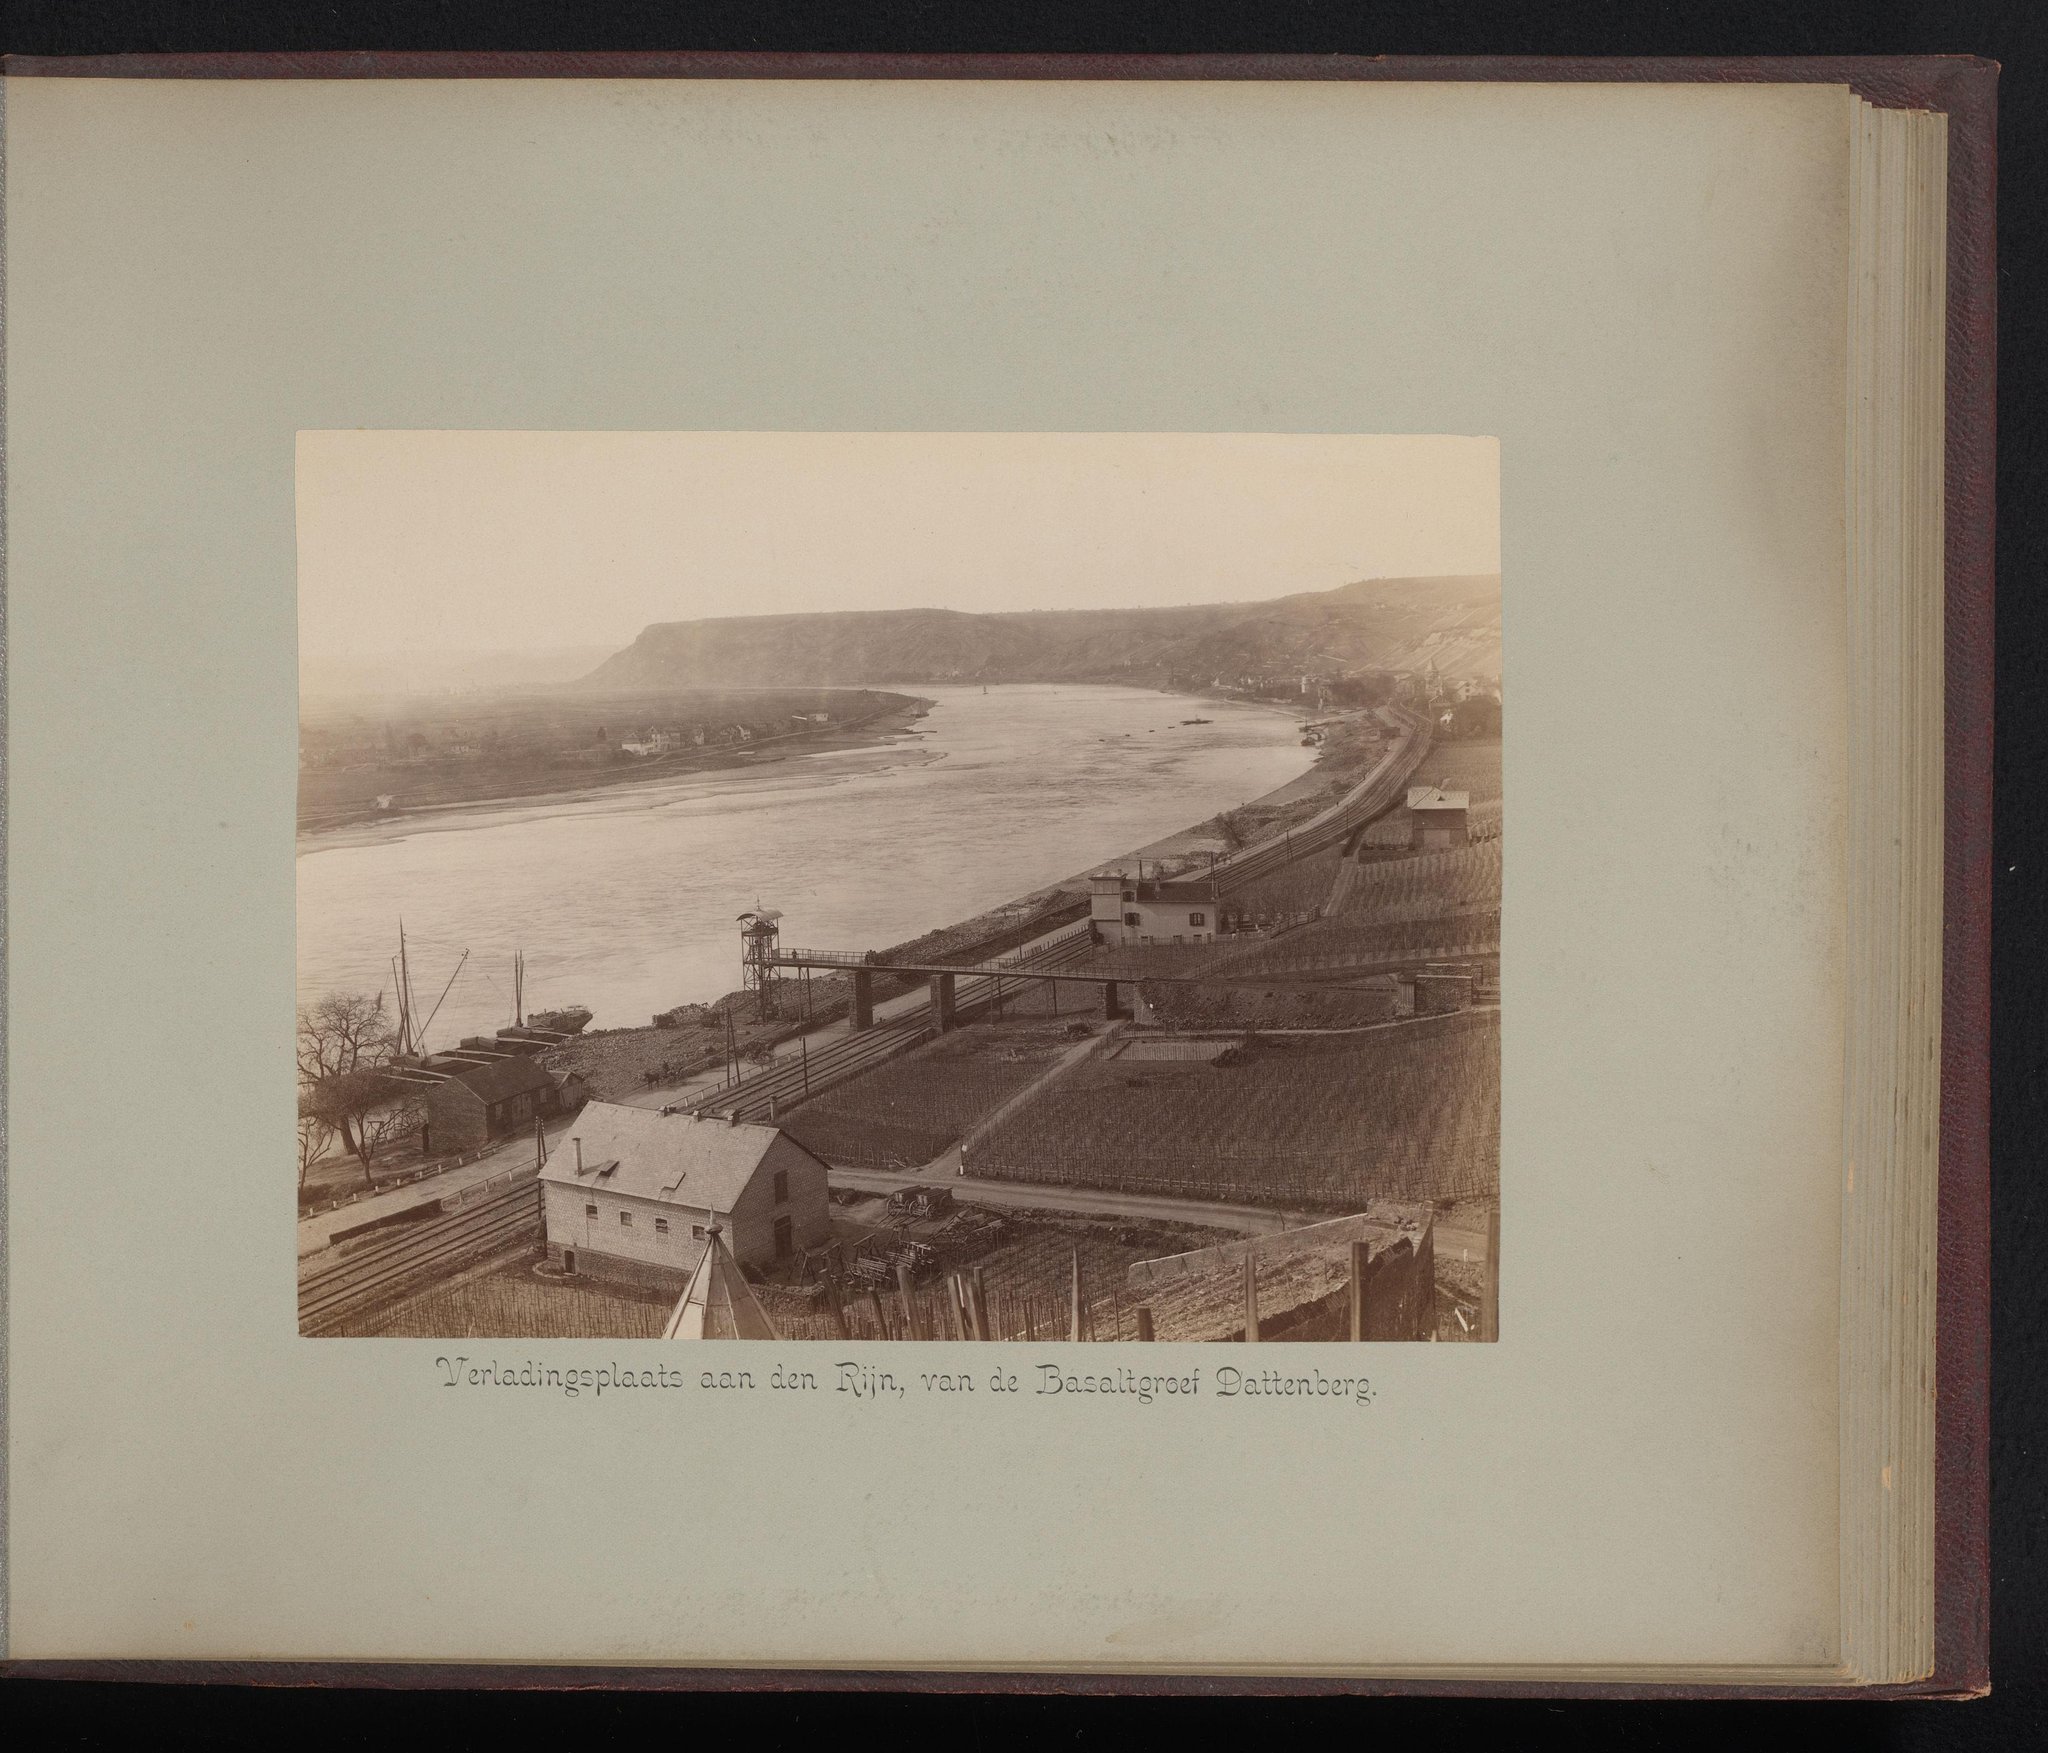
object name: photograph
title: Gezicht op een laadplaats van een basaltgroeve in Dattenberg, Duitsland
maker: Anonymous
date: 1883-1900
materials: cardboard, photographic support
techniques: albumen print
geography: dattenberg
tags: harbour, river, quarry